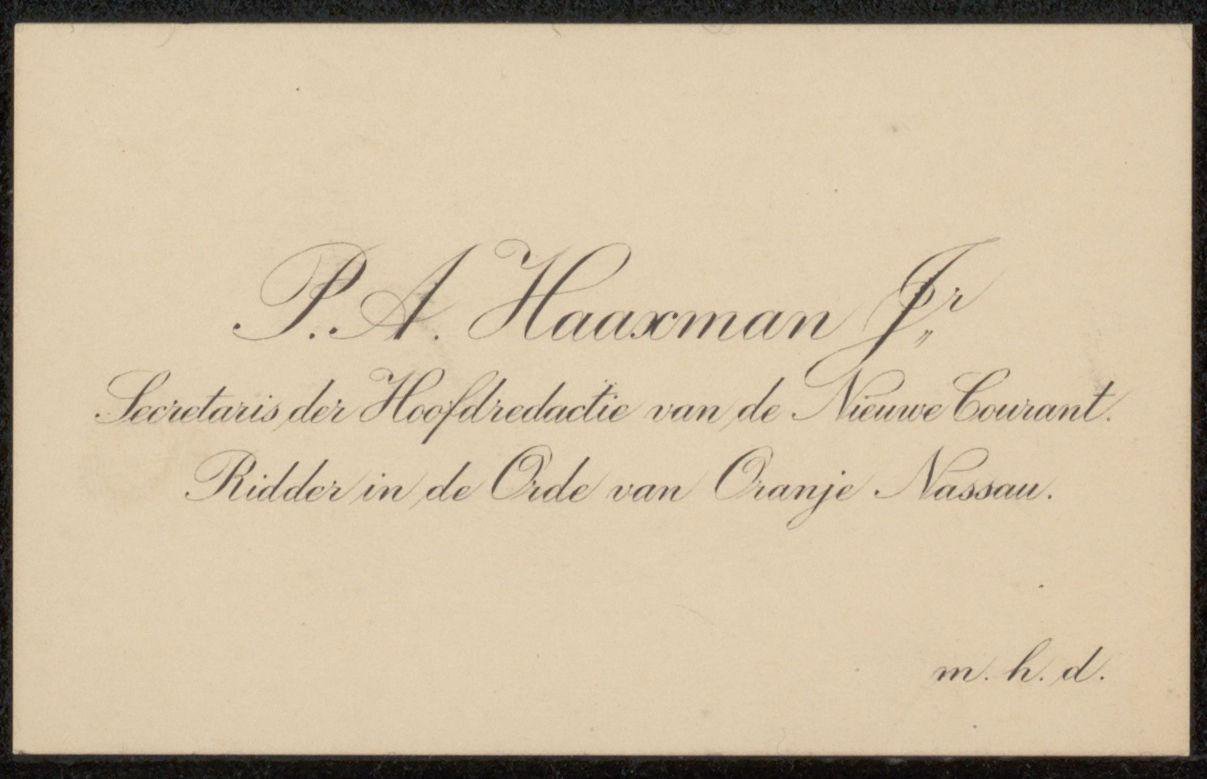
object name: visiting card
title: Visitekaartje aan Philip Zilcken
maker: pieter anne haaxman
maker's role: journalist, kunstcriticus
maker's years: 1847-1935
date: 1857-1935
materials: cardboard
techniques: printing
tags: the hague, painter, draughtsman, philip zilcken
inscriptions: collector's mark: ‘RPK’